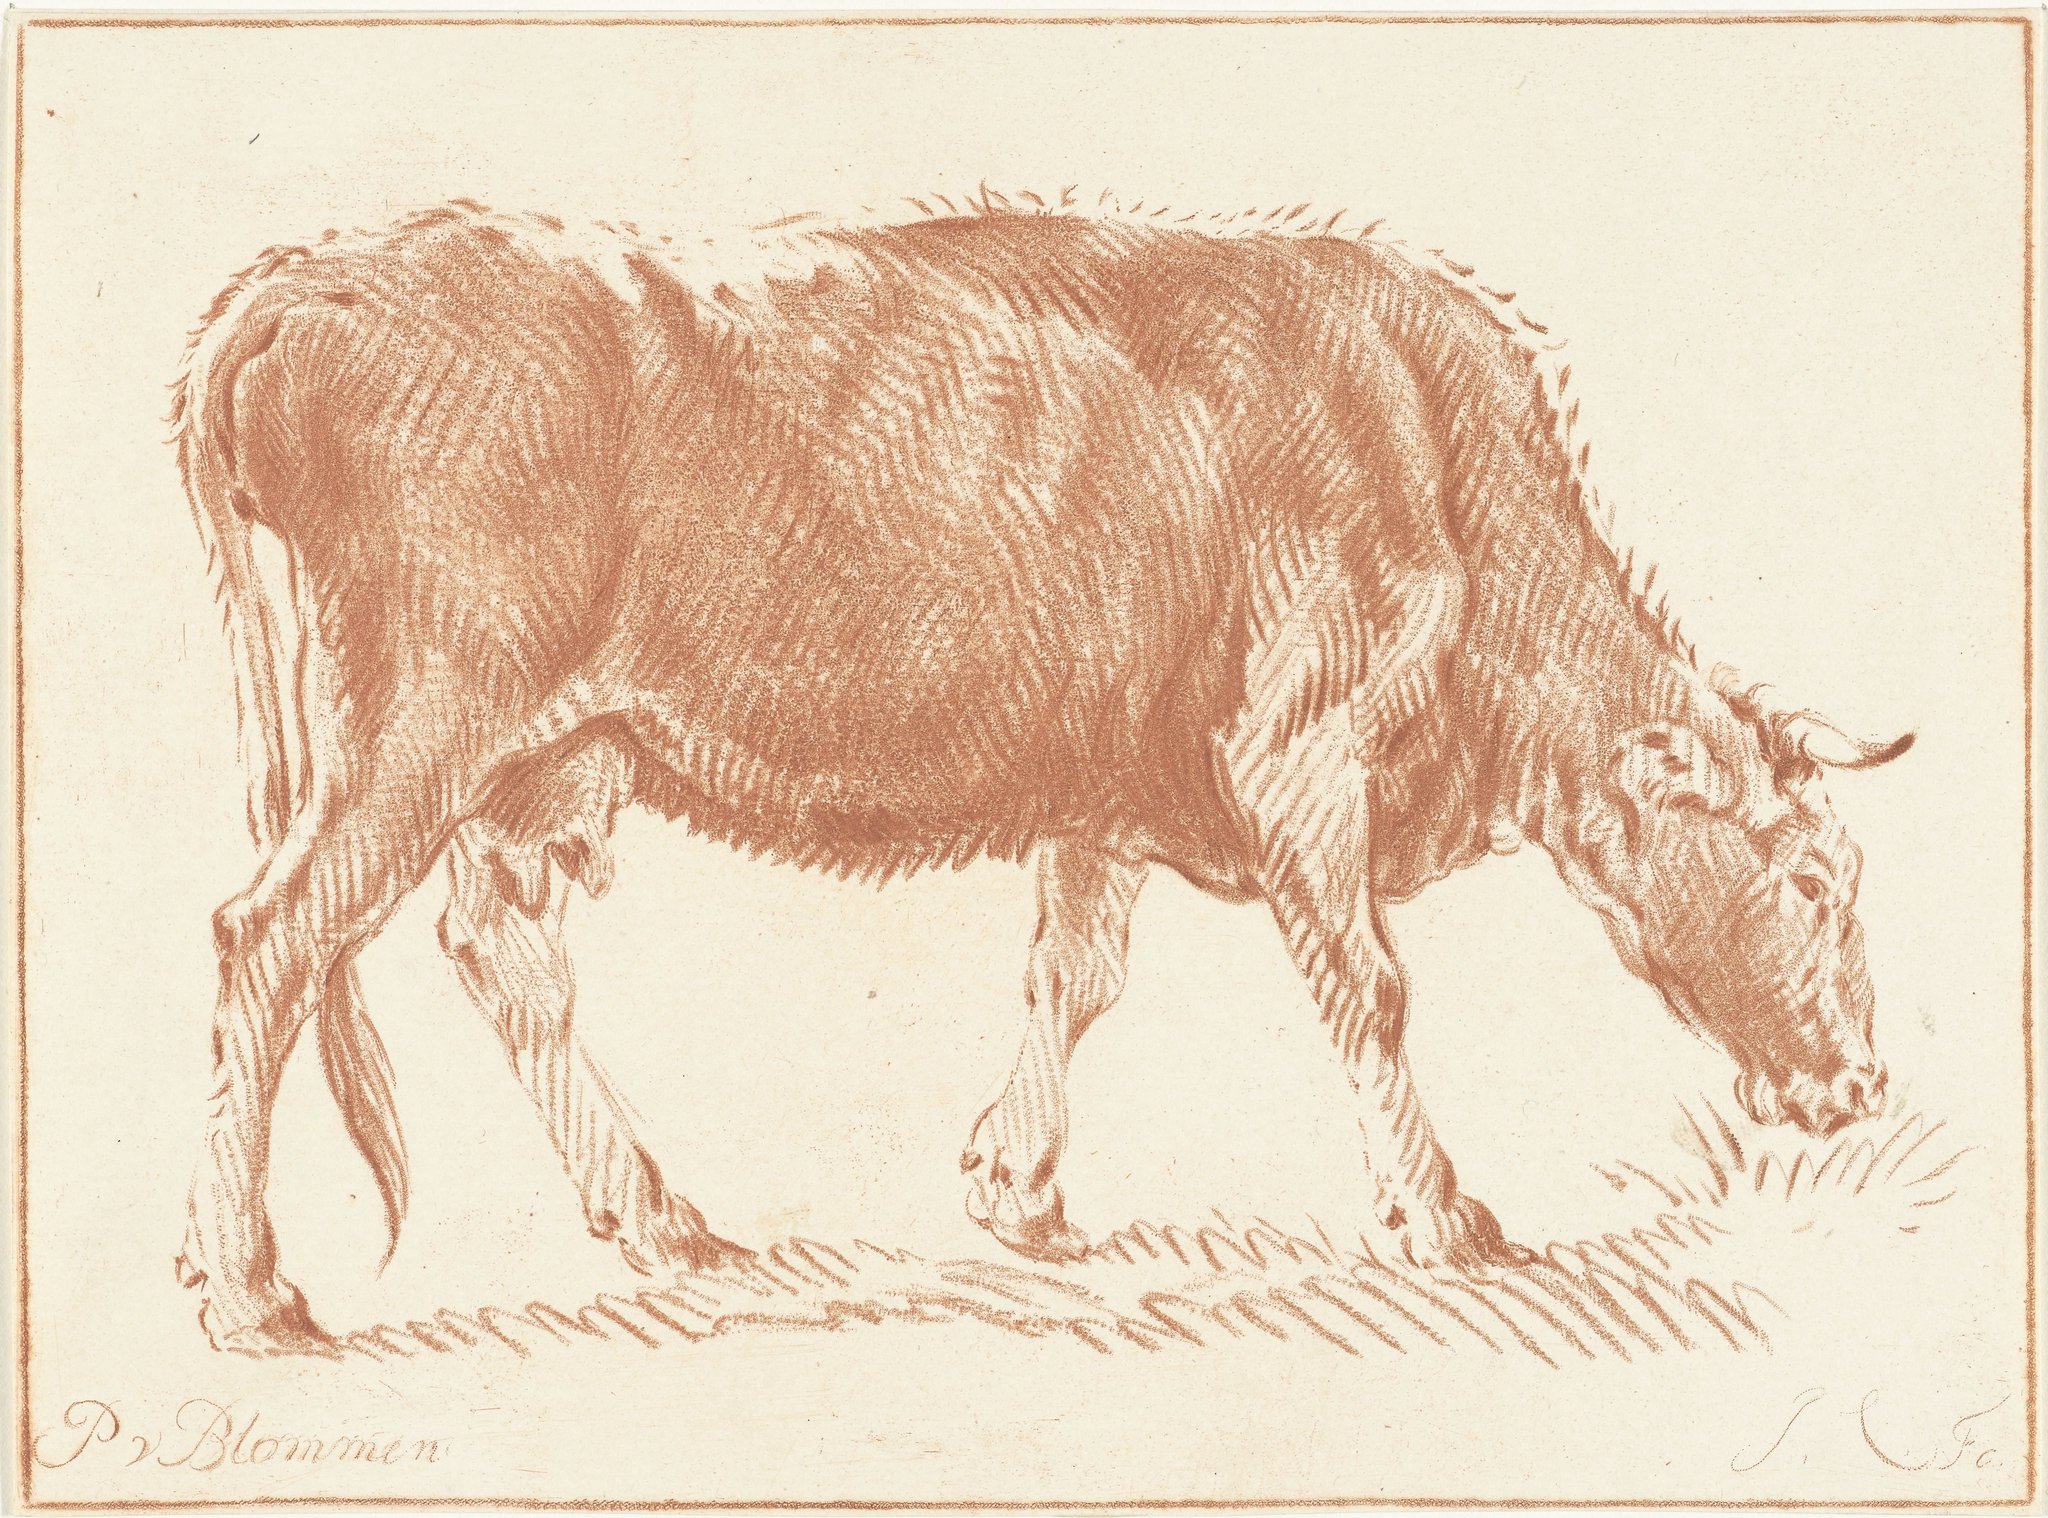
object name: print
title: Grazende koe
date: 1724-1798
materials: paper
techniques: printmaking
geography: antwerp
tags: cow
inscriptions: collector's mark: Lugt 2228